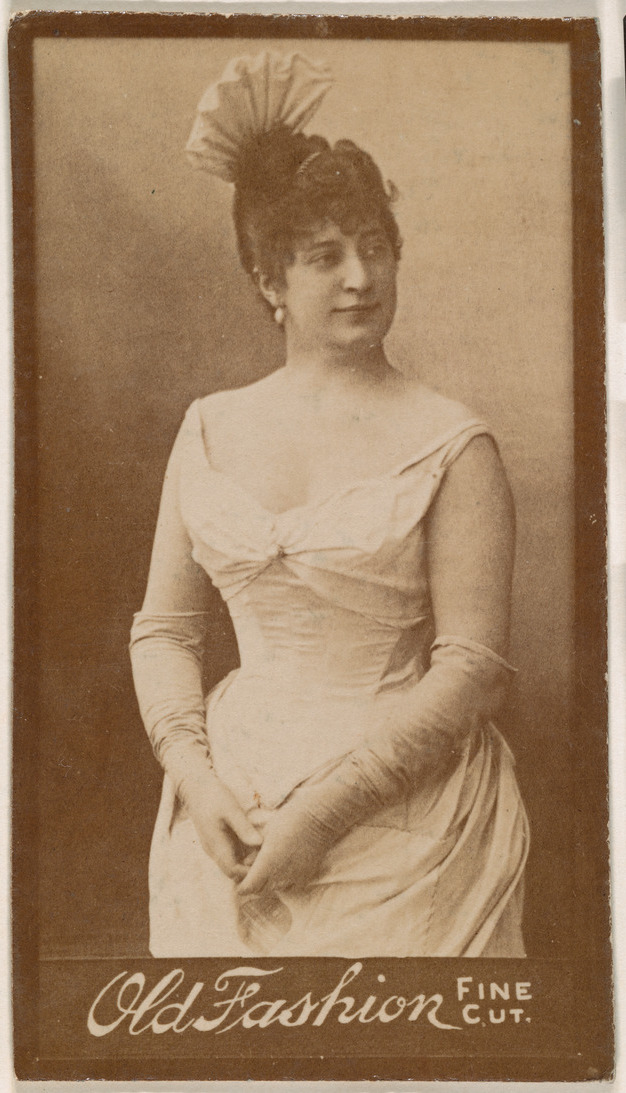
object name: photograph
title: Actress wearing feathered headpiece, from the Actresses series (N664) promoting Old Fashion Fine Cut Tobacco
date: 1888-1890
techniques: albumen silver print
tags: portraits,women,actresses